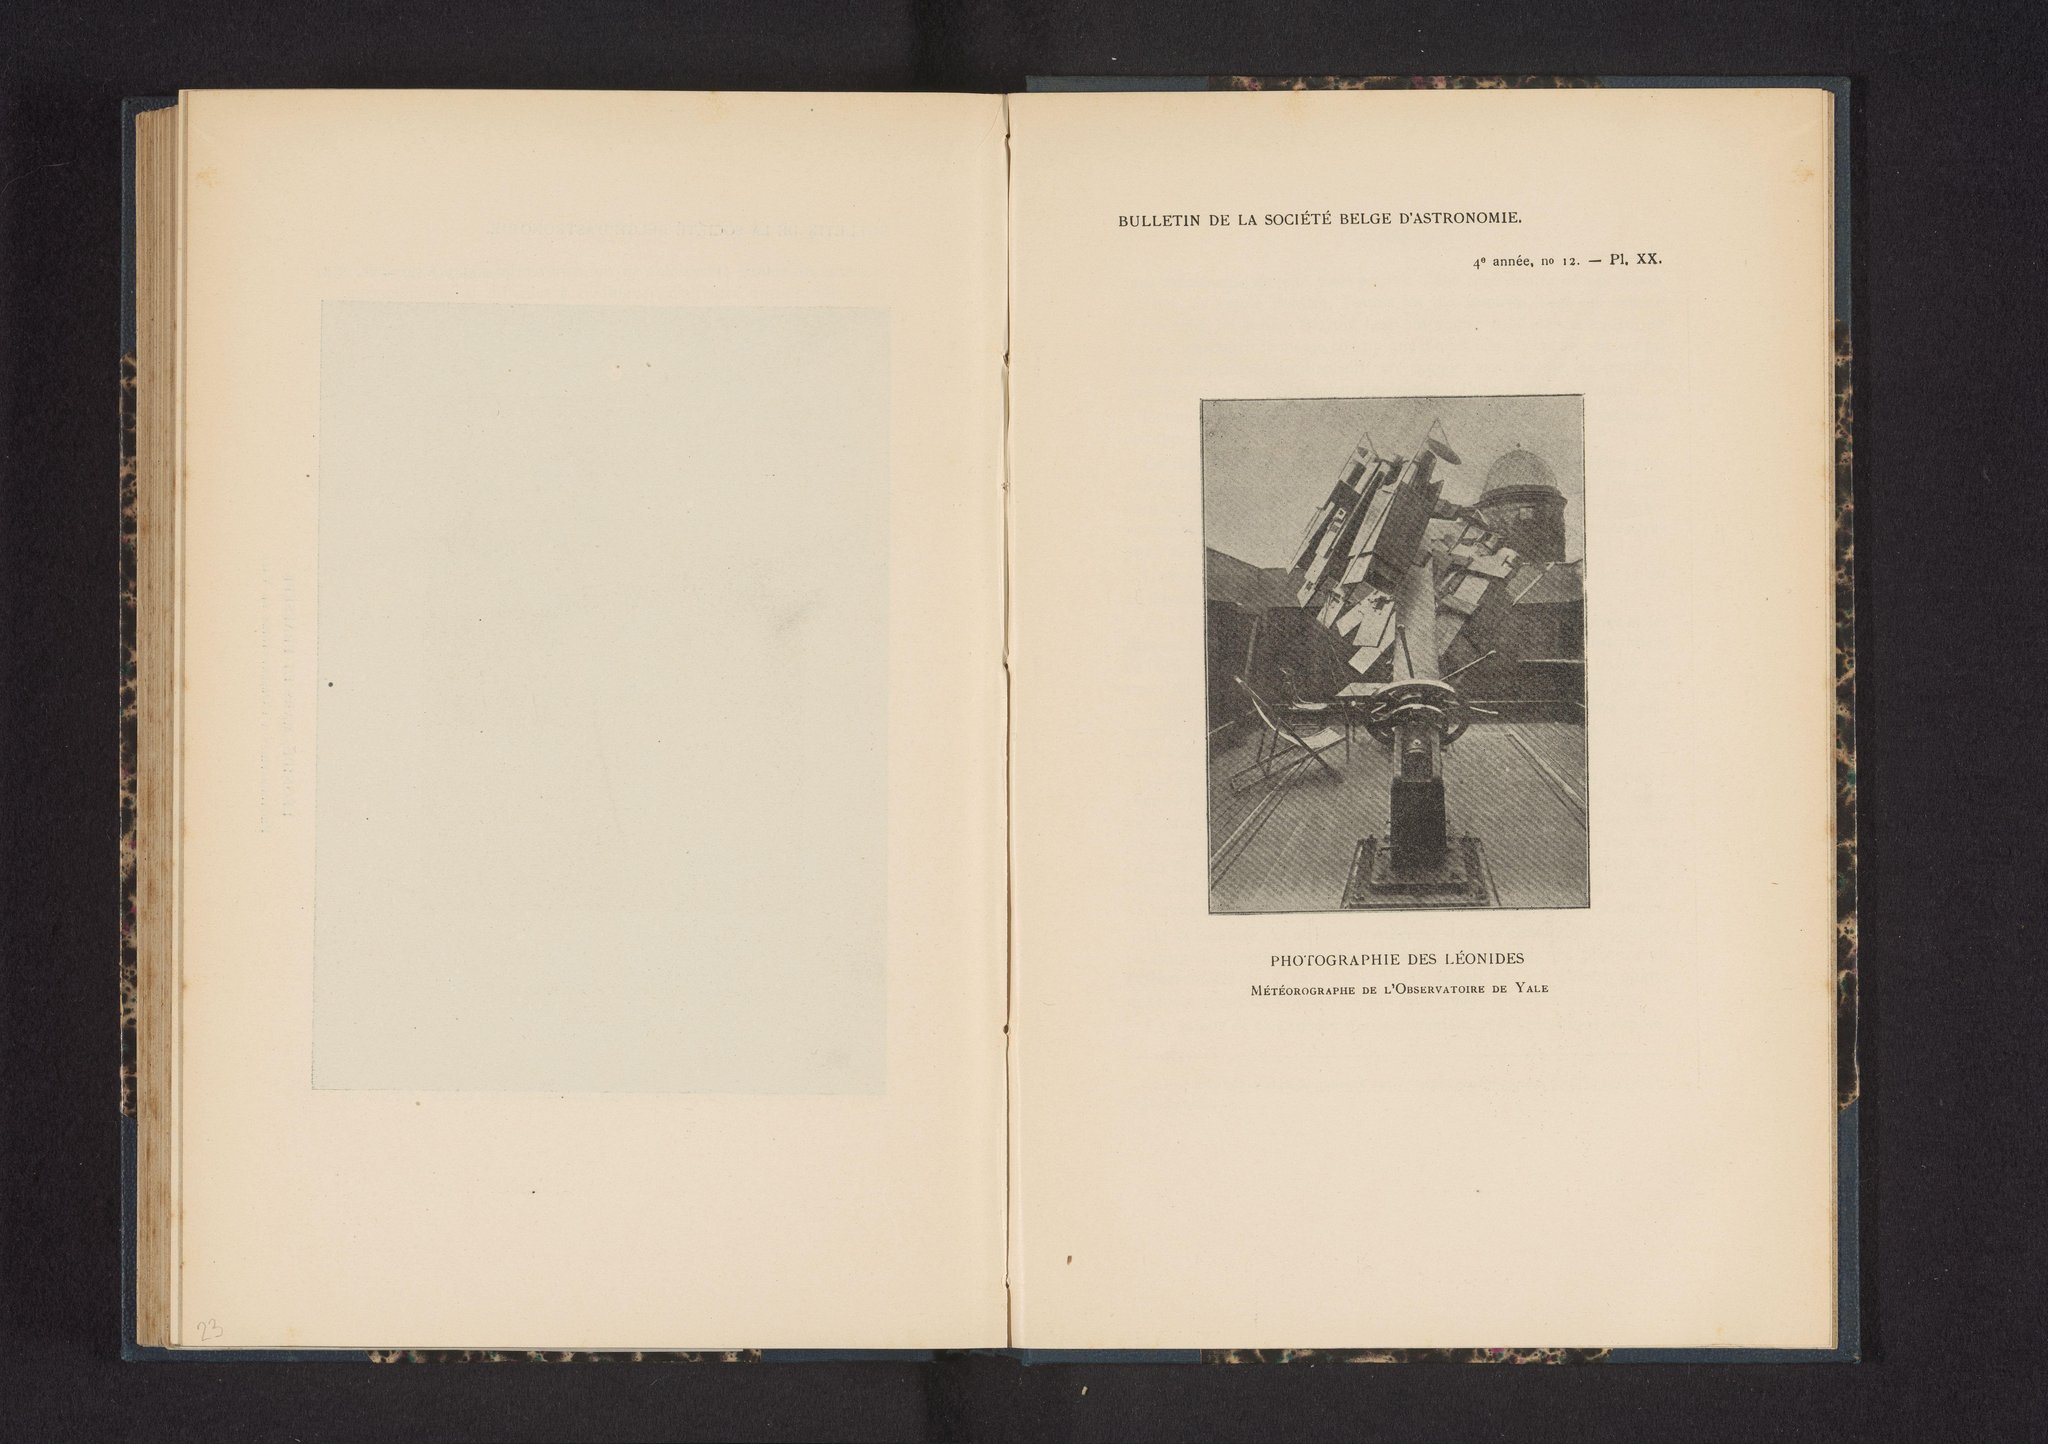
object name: photomechanical print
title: Photographie des Léonides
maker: Anonymous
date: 1894-1899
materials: paper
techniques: autotype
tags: meteorological observatory, telescope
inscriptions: inscription: ‘Météorographie de l'Observatoire de Yale’